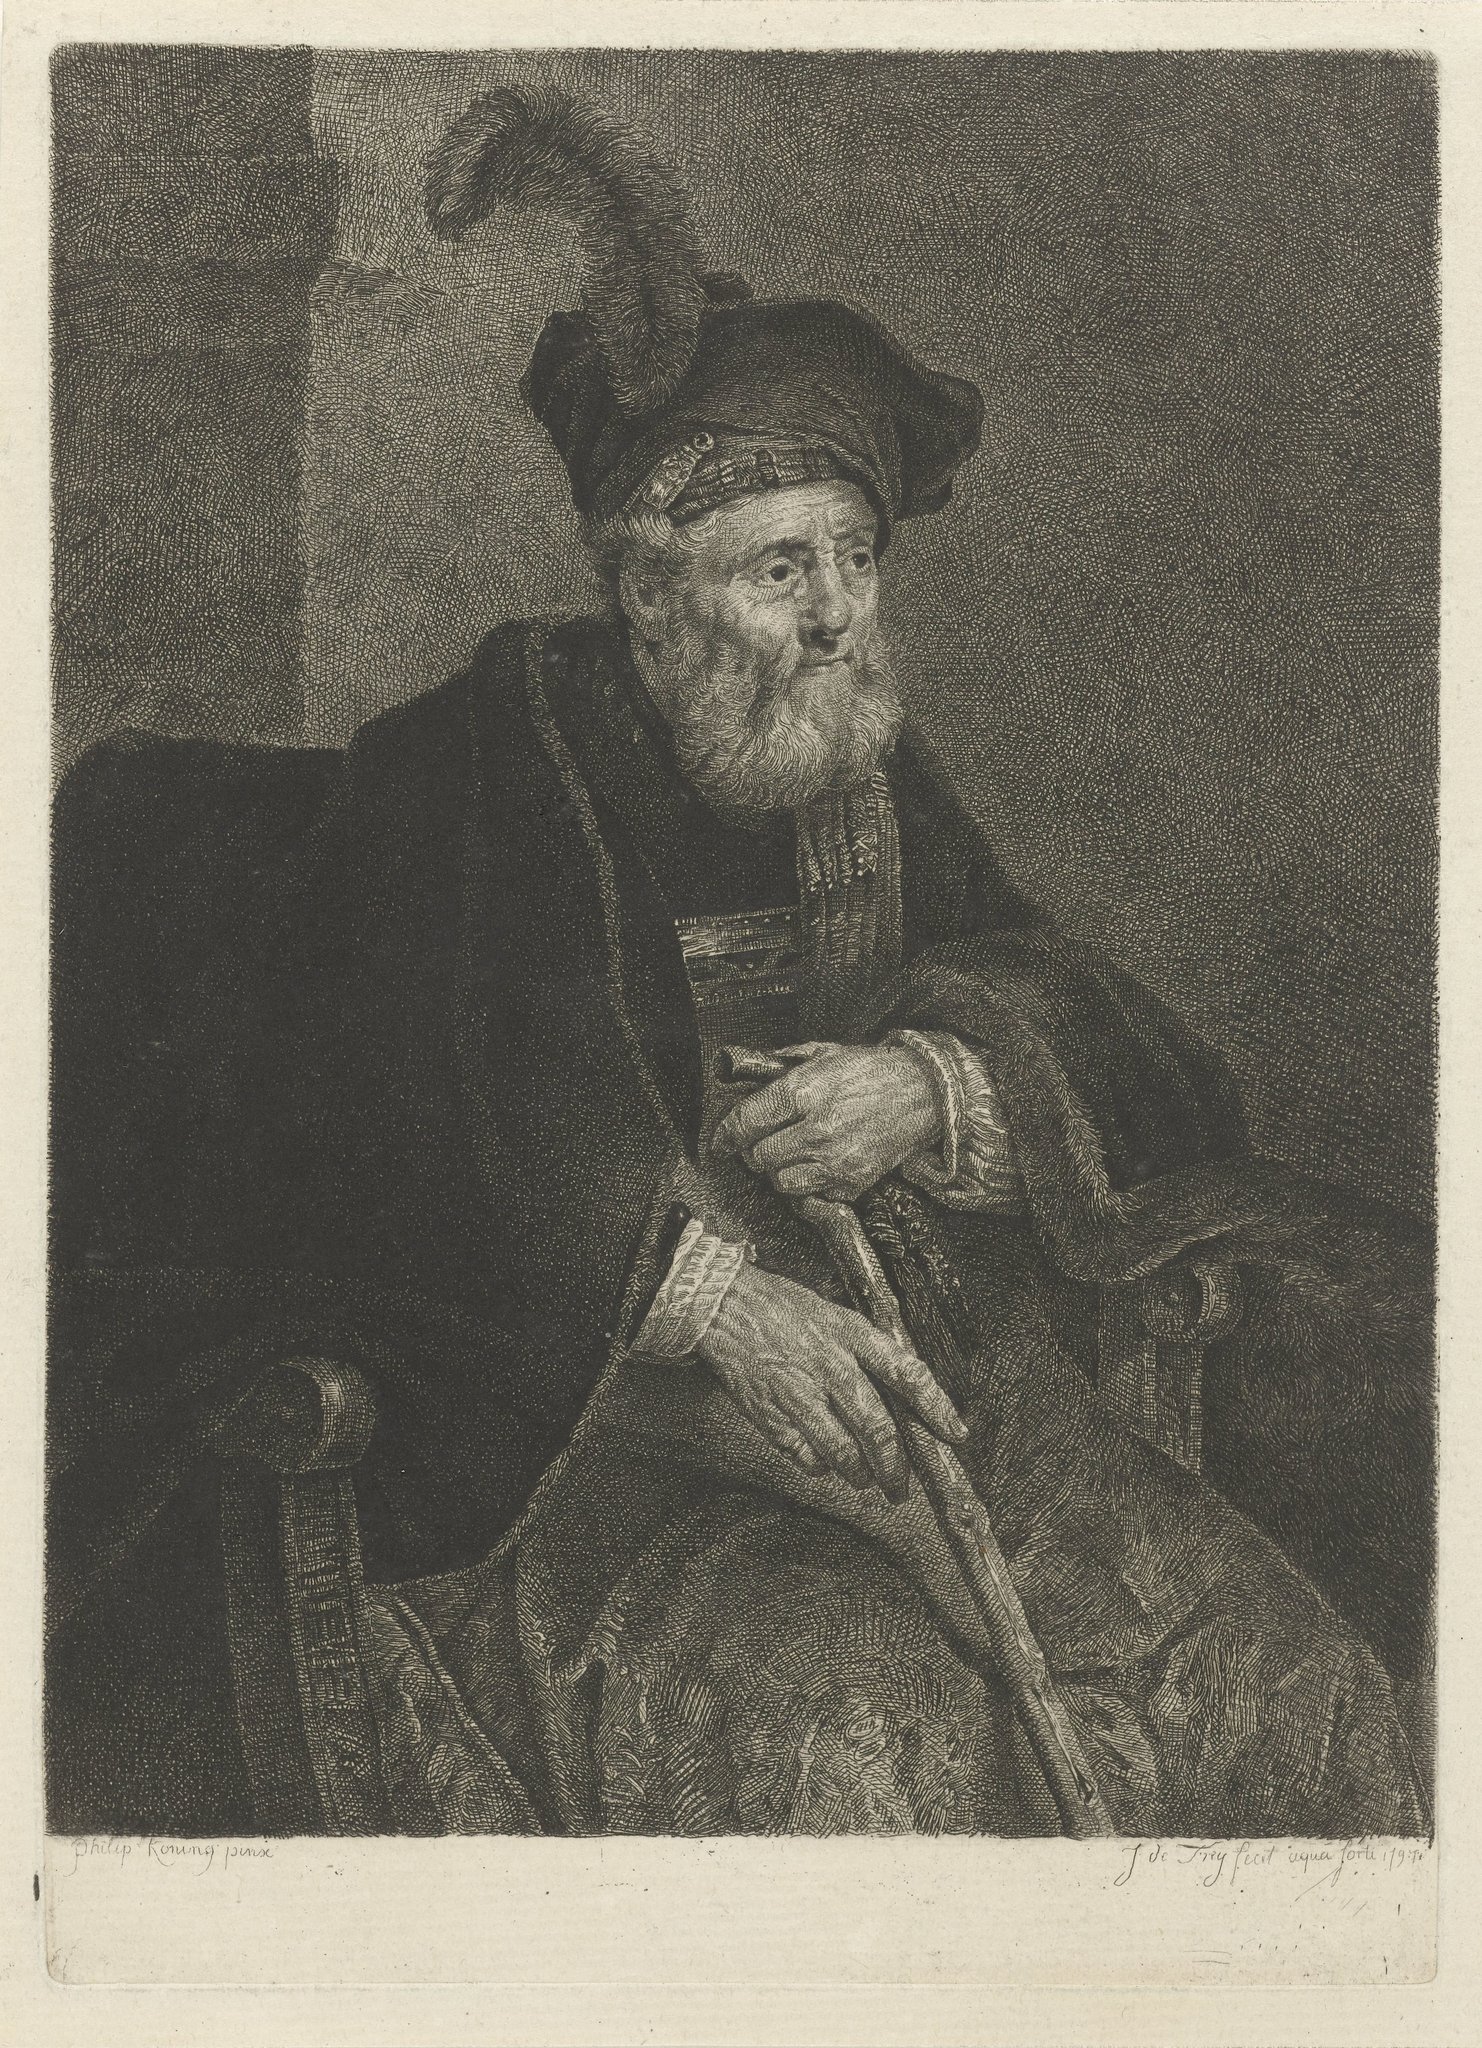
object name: print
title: Portret van een onbekende oude man in een stoel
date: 1797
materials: paper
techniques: etching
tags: sitting figure, head-gear (+ feathers used for clothes), old man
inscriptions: collector's mark: Lugt 2228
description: Portret van een onbekende oude man in een stoel. Kniestuk, zittend naar rechts gedraaid. Zijn handen omklemmen een wandelstok. De man is gehuld in een met bont omzoomde mantel, zijn hoofd is getooid met een gevederde hoed.